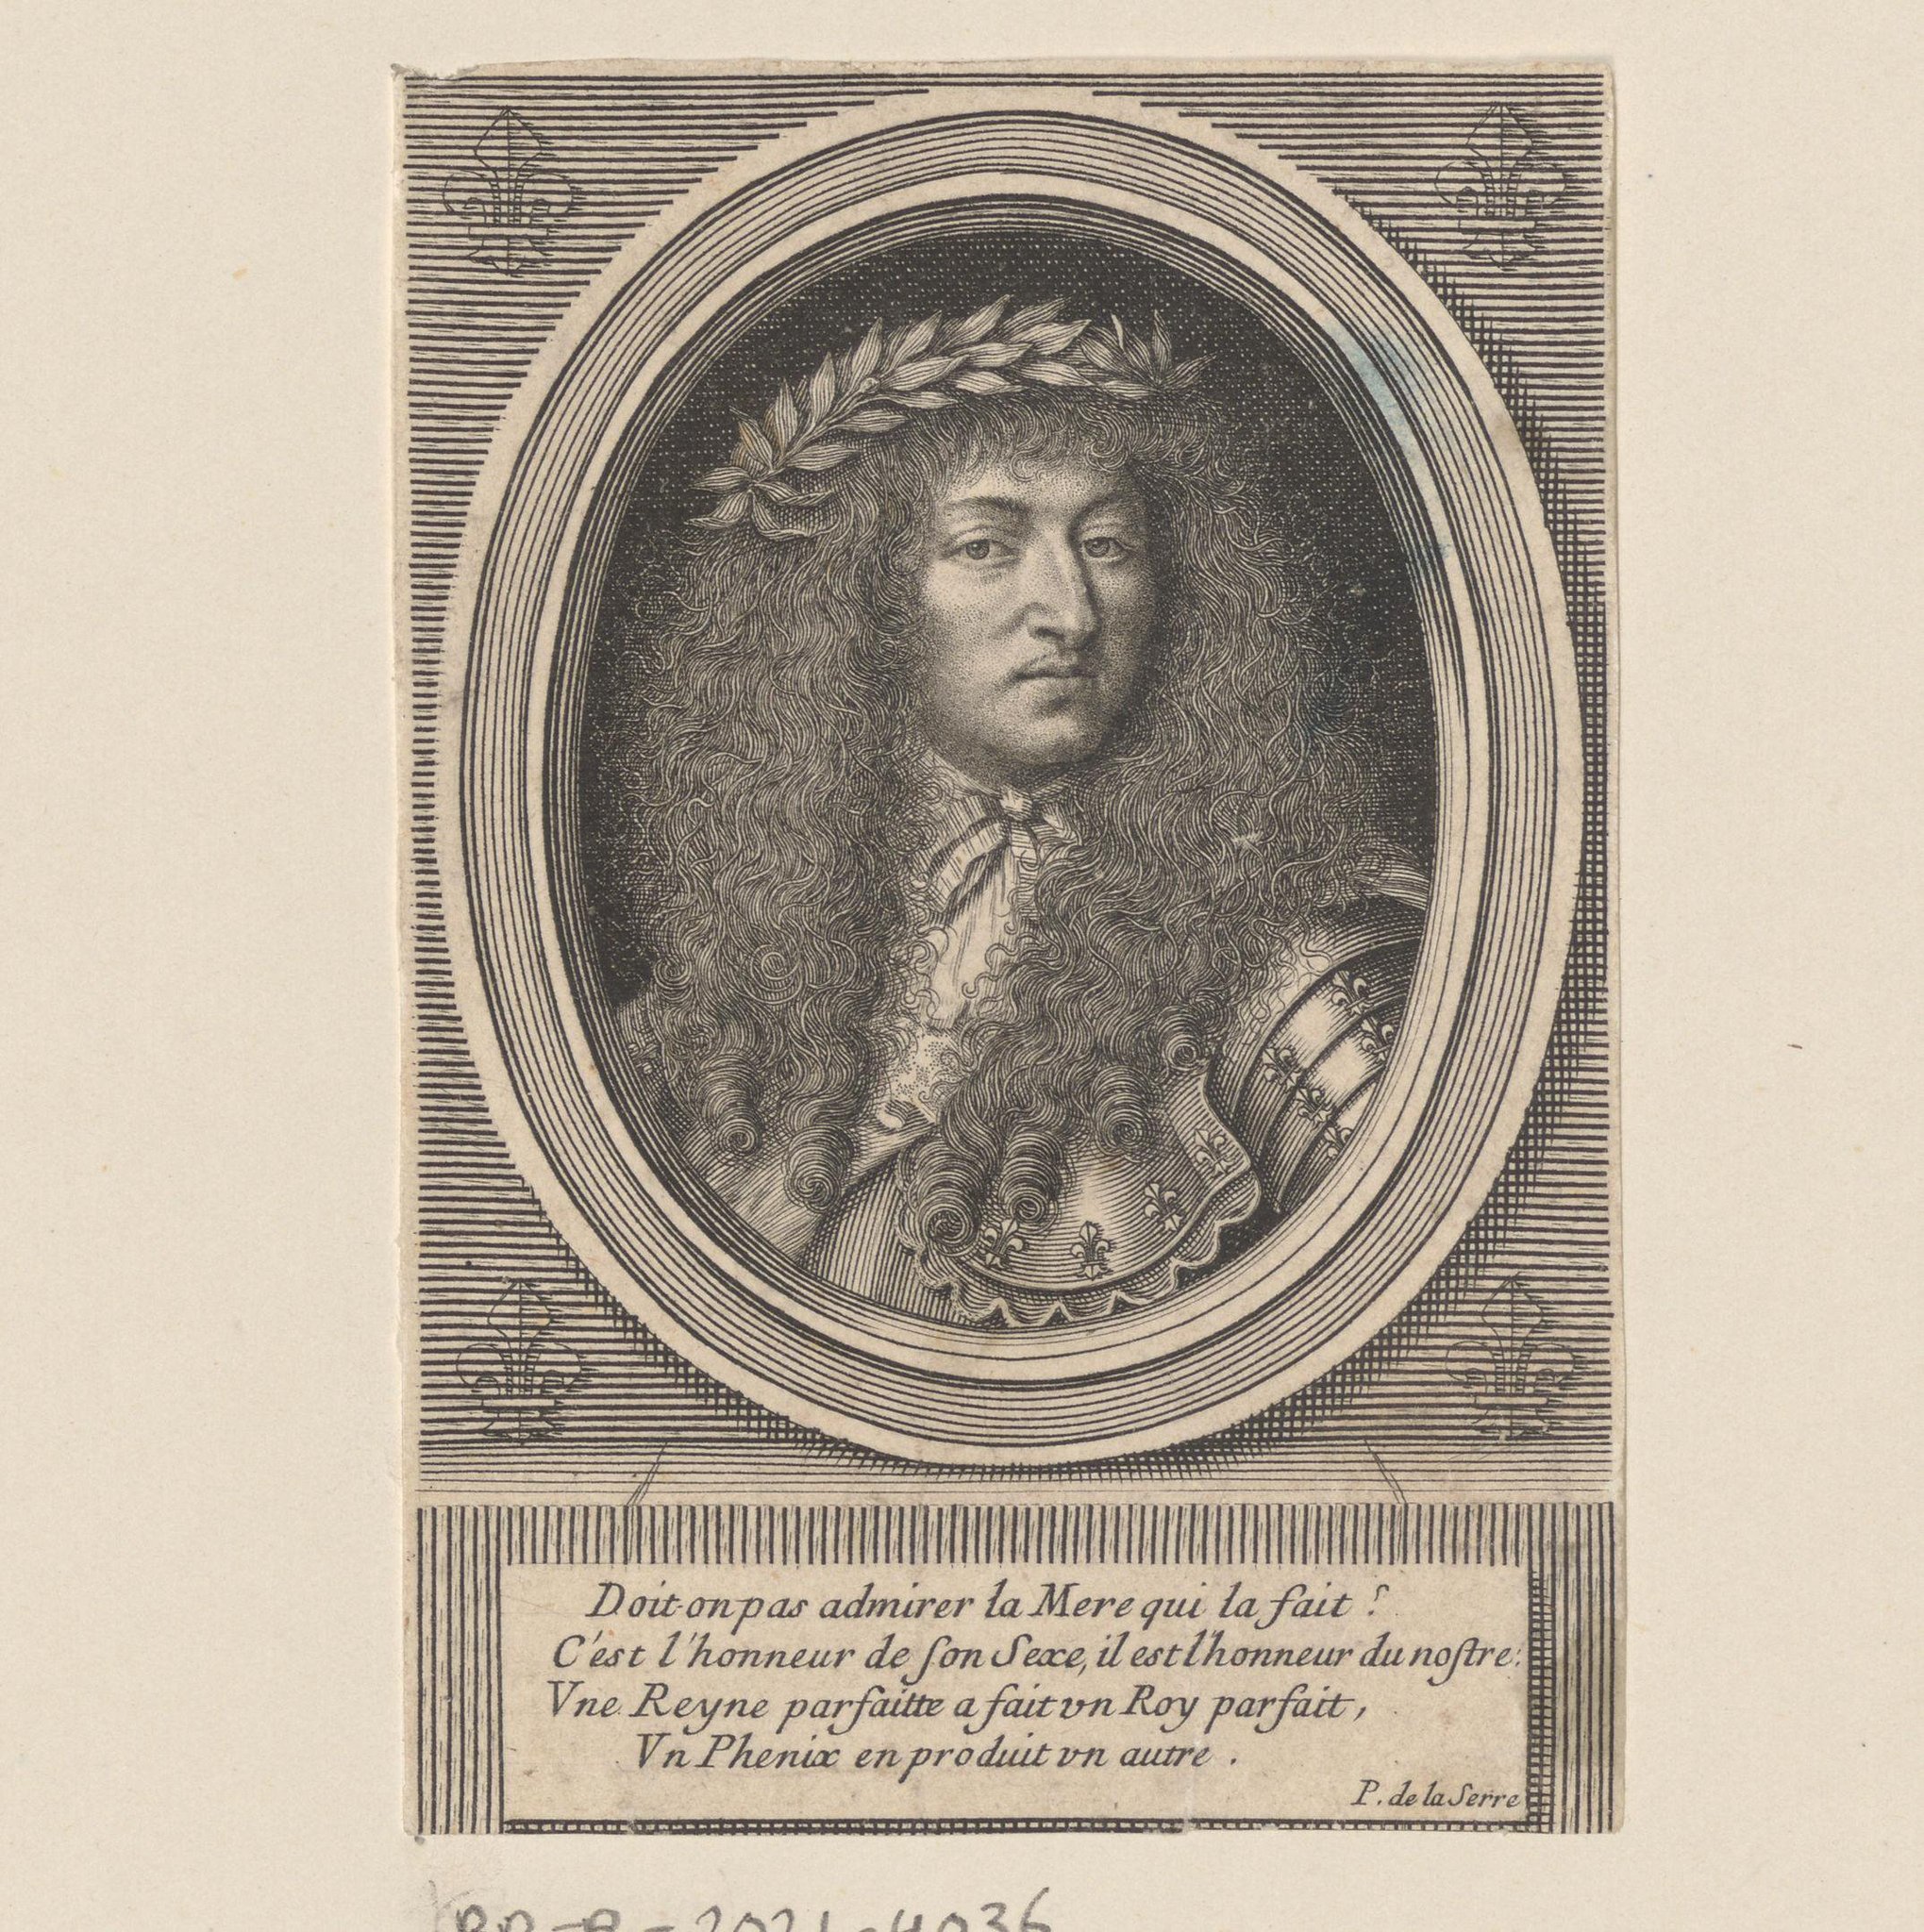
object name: print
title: Portret van Lodewijk XIV van Frankrijk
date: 1658-1699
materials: paper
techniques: engraving, etching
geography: france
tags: lodewijk xiv (koning van frankrijk), fleur-de-lis ~ ornament, ornament ~ medallion, armour, historical persons, king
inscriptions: collector's mark: Lugt 240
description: Met vierregelig vers in het Frans onder het portret.